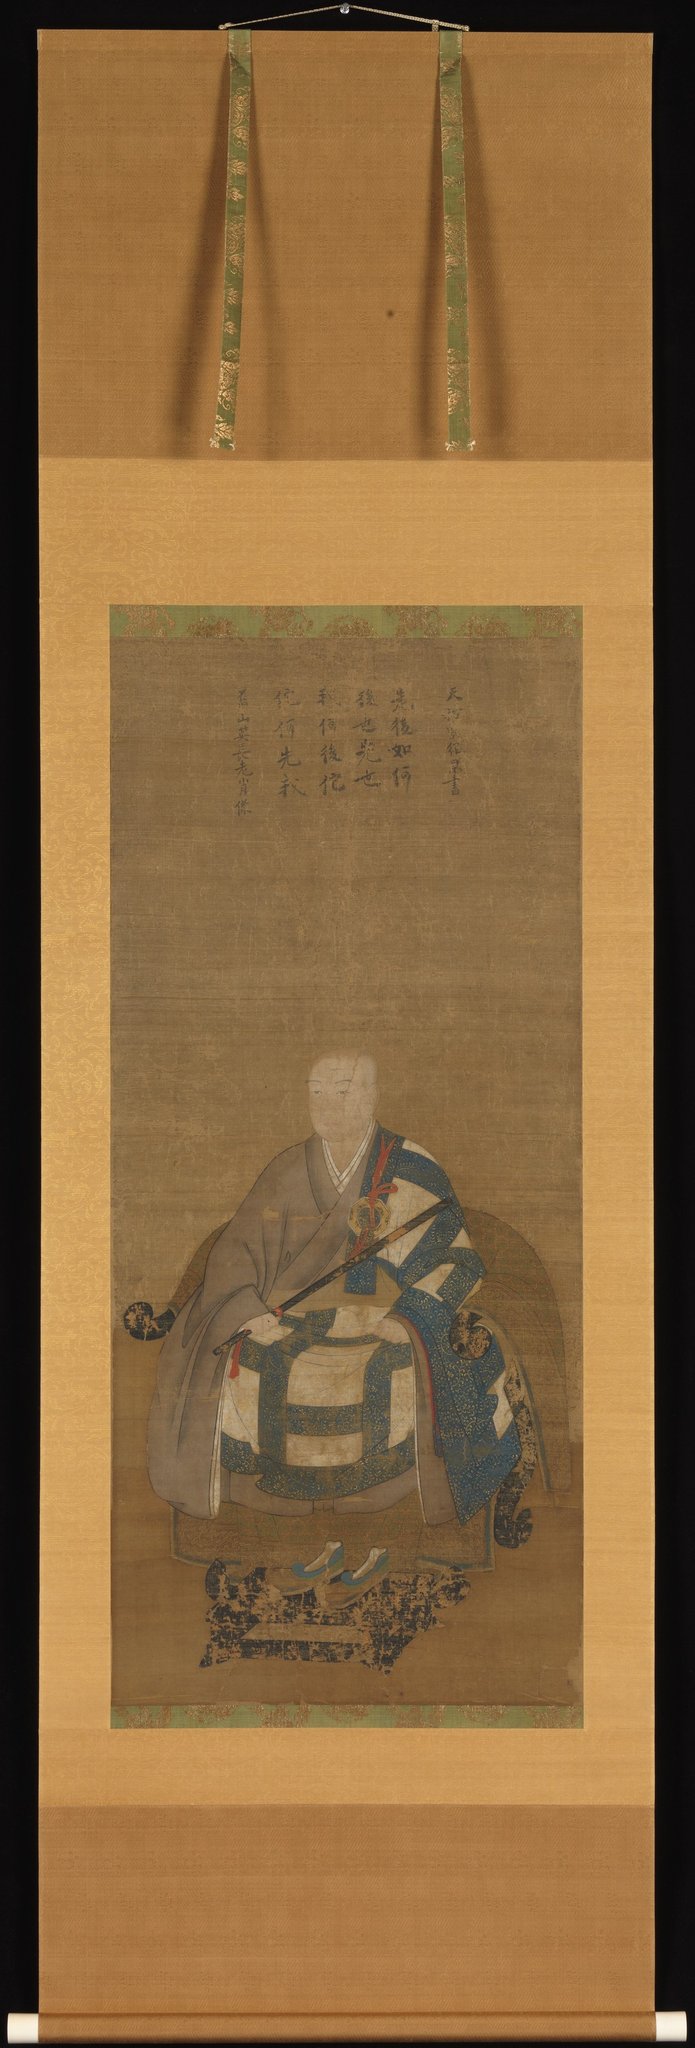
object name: hanging scroll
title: Portrait of Kyūzan Sōei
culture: japanese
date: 1601-1700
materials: ink, silk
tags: men,portraits,buddhism